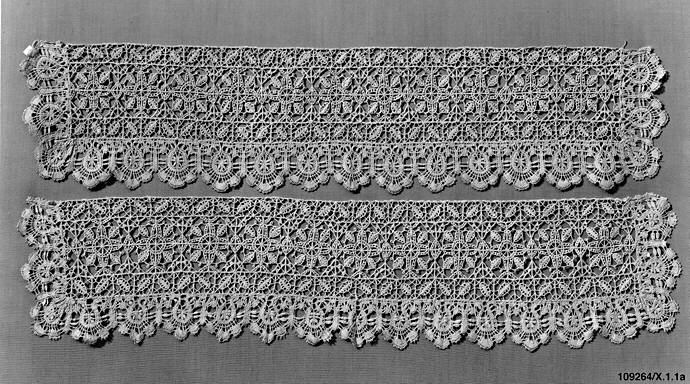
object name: cuff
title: Pair of cuffs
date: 1501-1600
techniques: lace